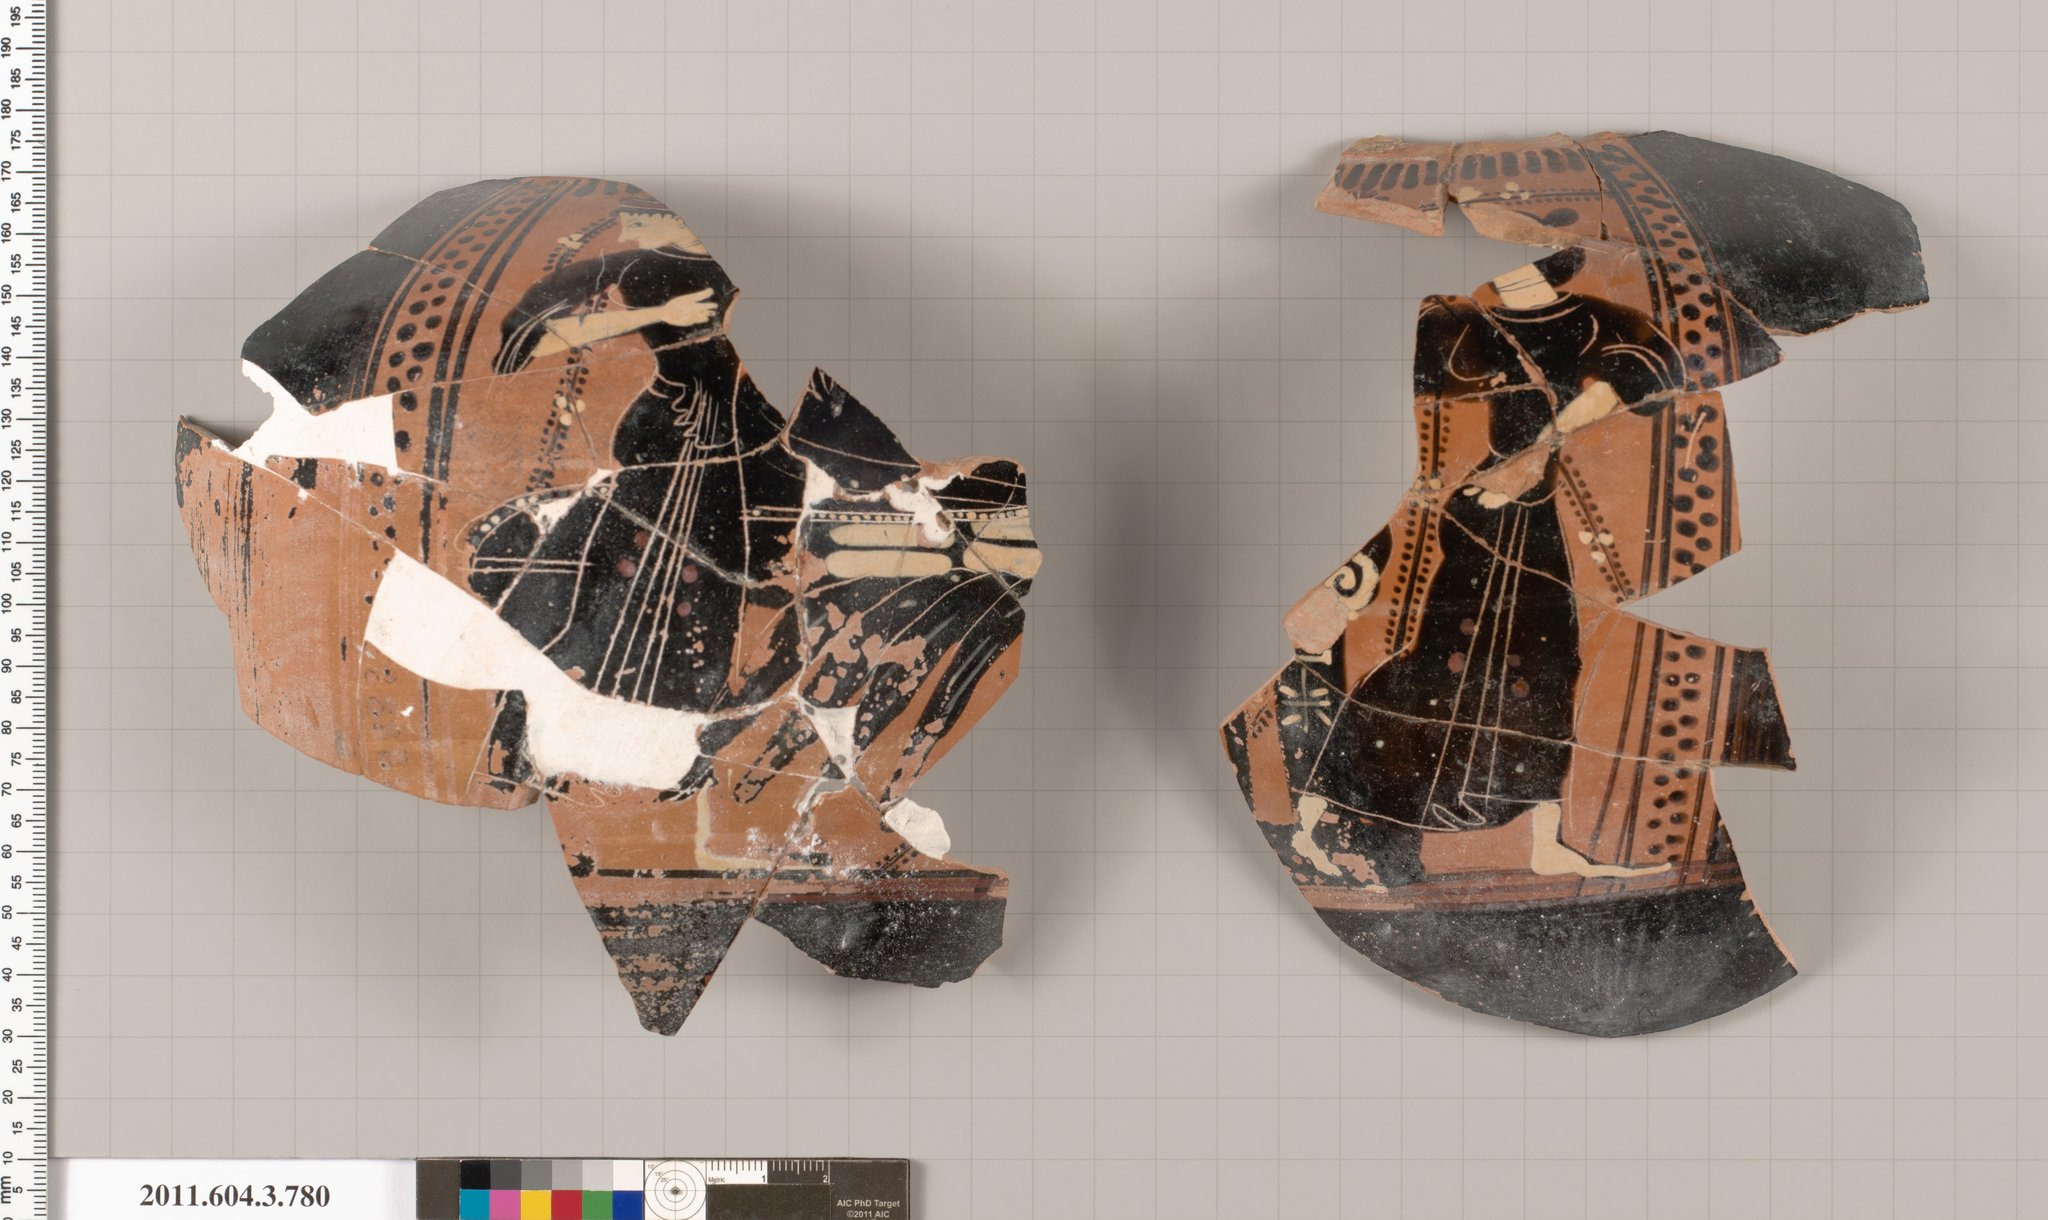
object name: oinochoe fragment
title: Terracotta fragment of an oinochoe (jug)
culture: greek, attic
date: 500-468 BCE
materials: terracotta